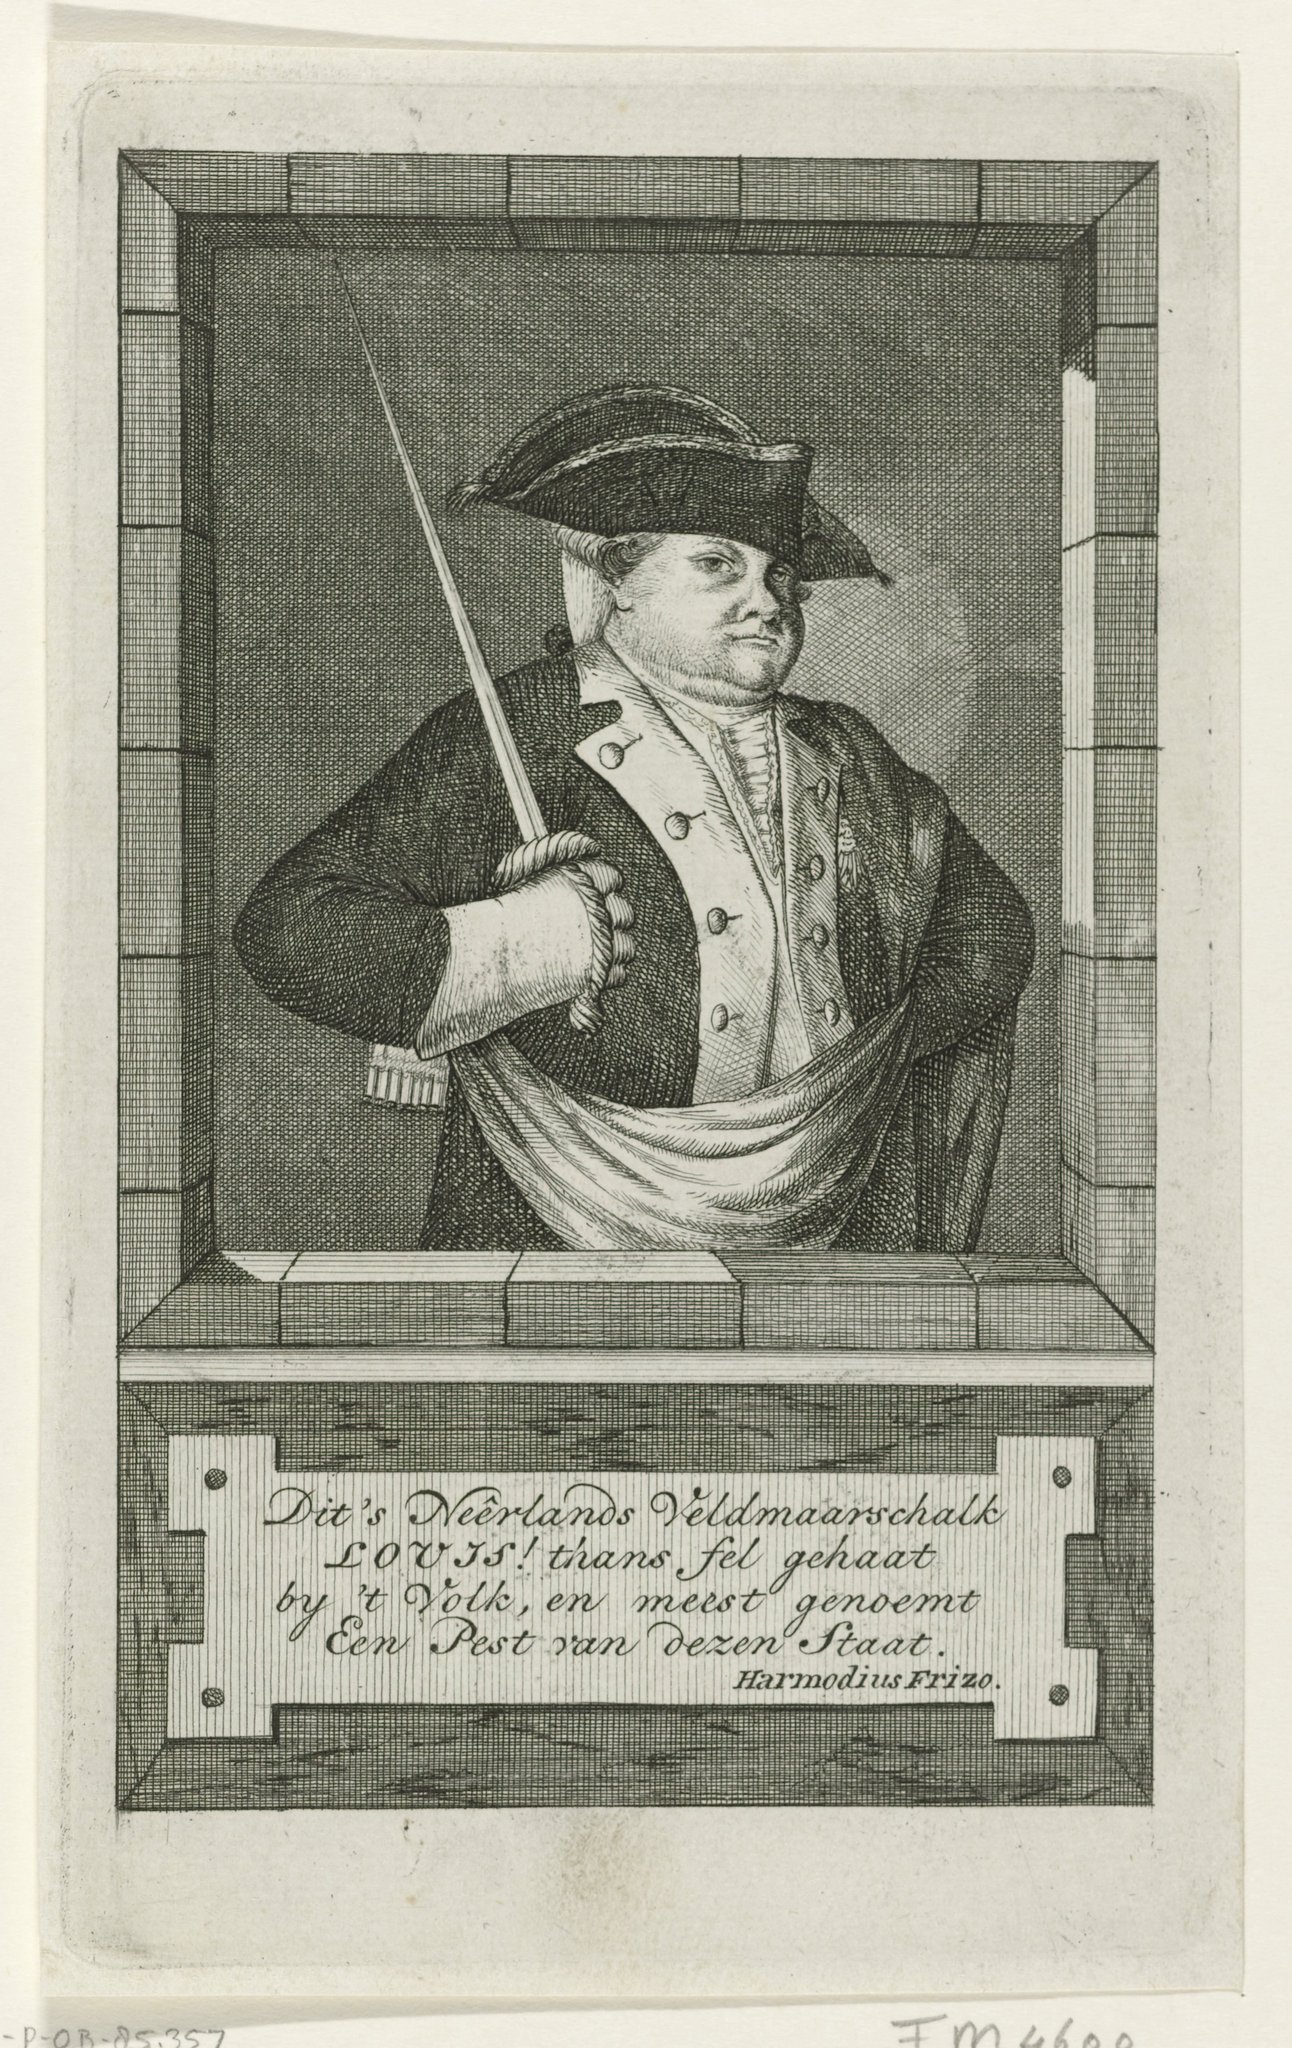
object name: print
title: Portret van de hertog van Brunswijk, 1782-1783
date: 1782-1783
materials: paper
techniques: engraving, etching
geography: northern netherlands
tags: ludwig ernst von braunschweig-wolfenbüttel, patriots (1780-1795)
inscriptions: collector's mark: Lugt 2228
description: Spotprent op de hertog van Brunswijk, ca. 1782-1783. Portret ten halven lijve, staande met getrokken degen, binnen een stenen kader. Onder het portret een vierregelig vers. Bij de prent behoort een blad met spotverzen op het portret.